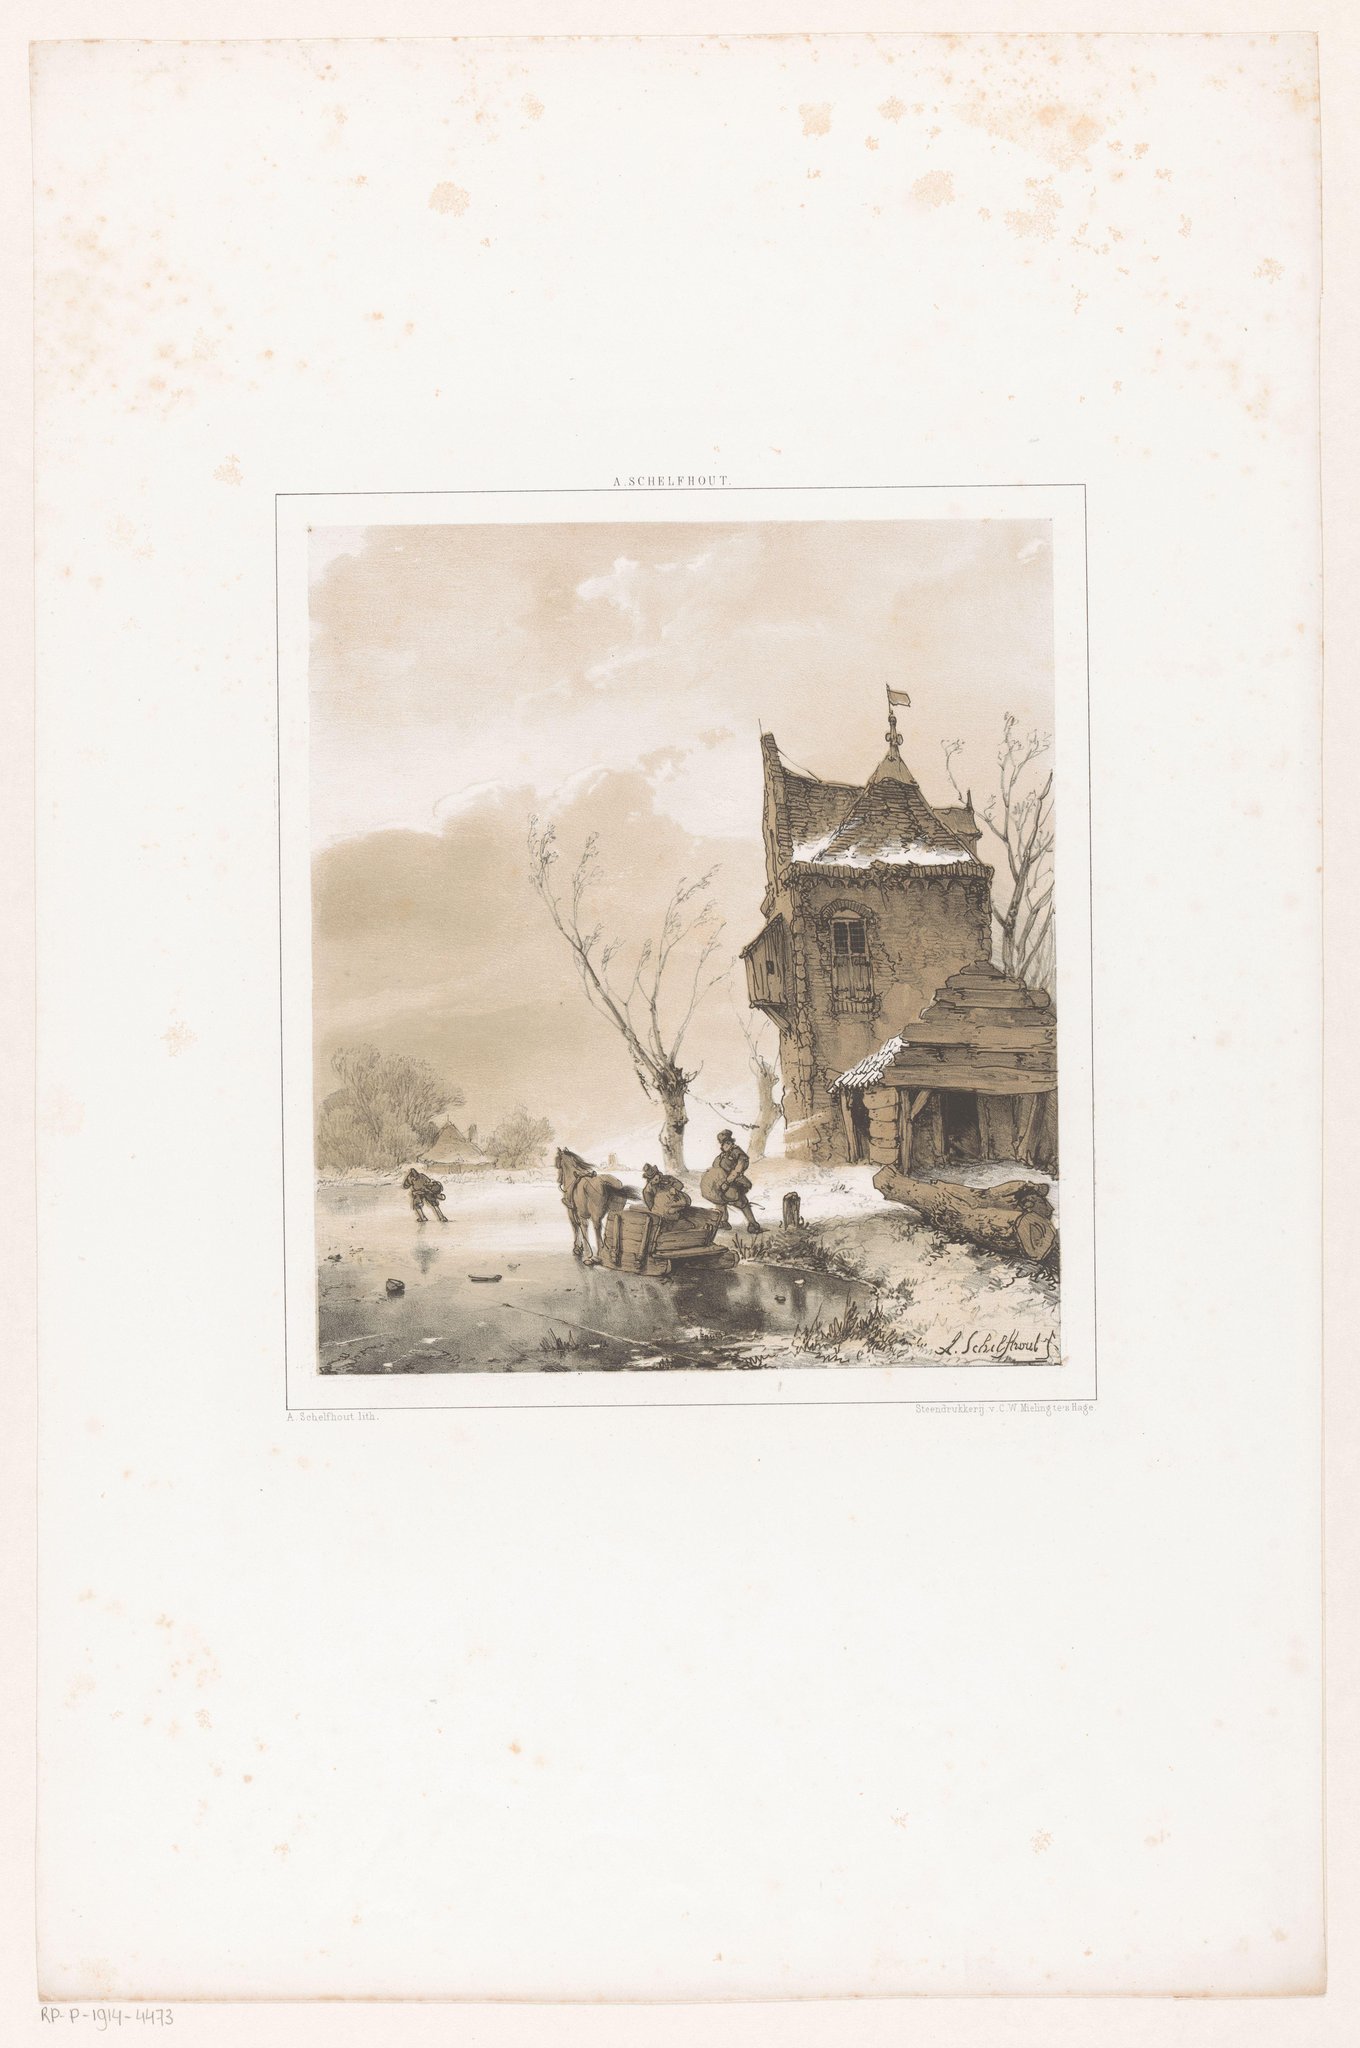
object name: print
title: Mannen laden slee vol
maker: andreas schelfhout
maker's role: draughtsman, painter, print maker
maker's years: 1787-1870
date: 1847-1865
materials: paper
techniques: tone lithography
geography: the hague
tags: sleigh, sledge (non-sport)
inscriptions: collector's mark: Lugt 2228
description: Op een bevroren rivier naast een huis staat een paard met slee. Twee mannen laden de slee vol. In de achtergrond een figuur op het ijs en huizen langs de oever.